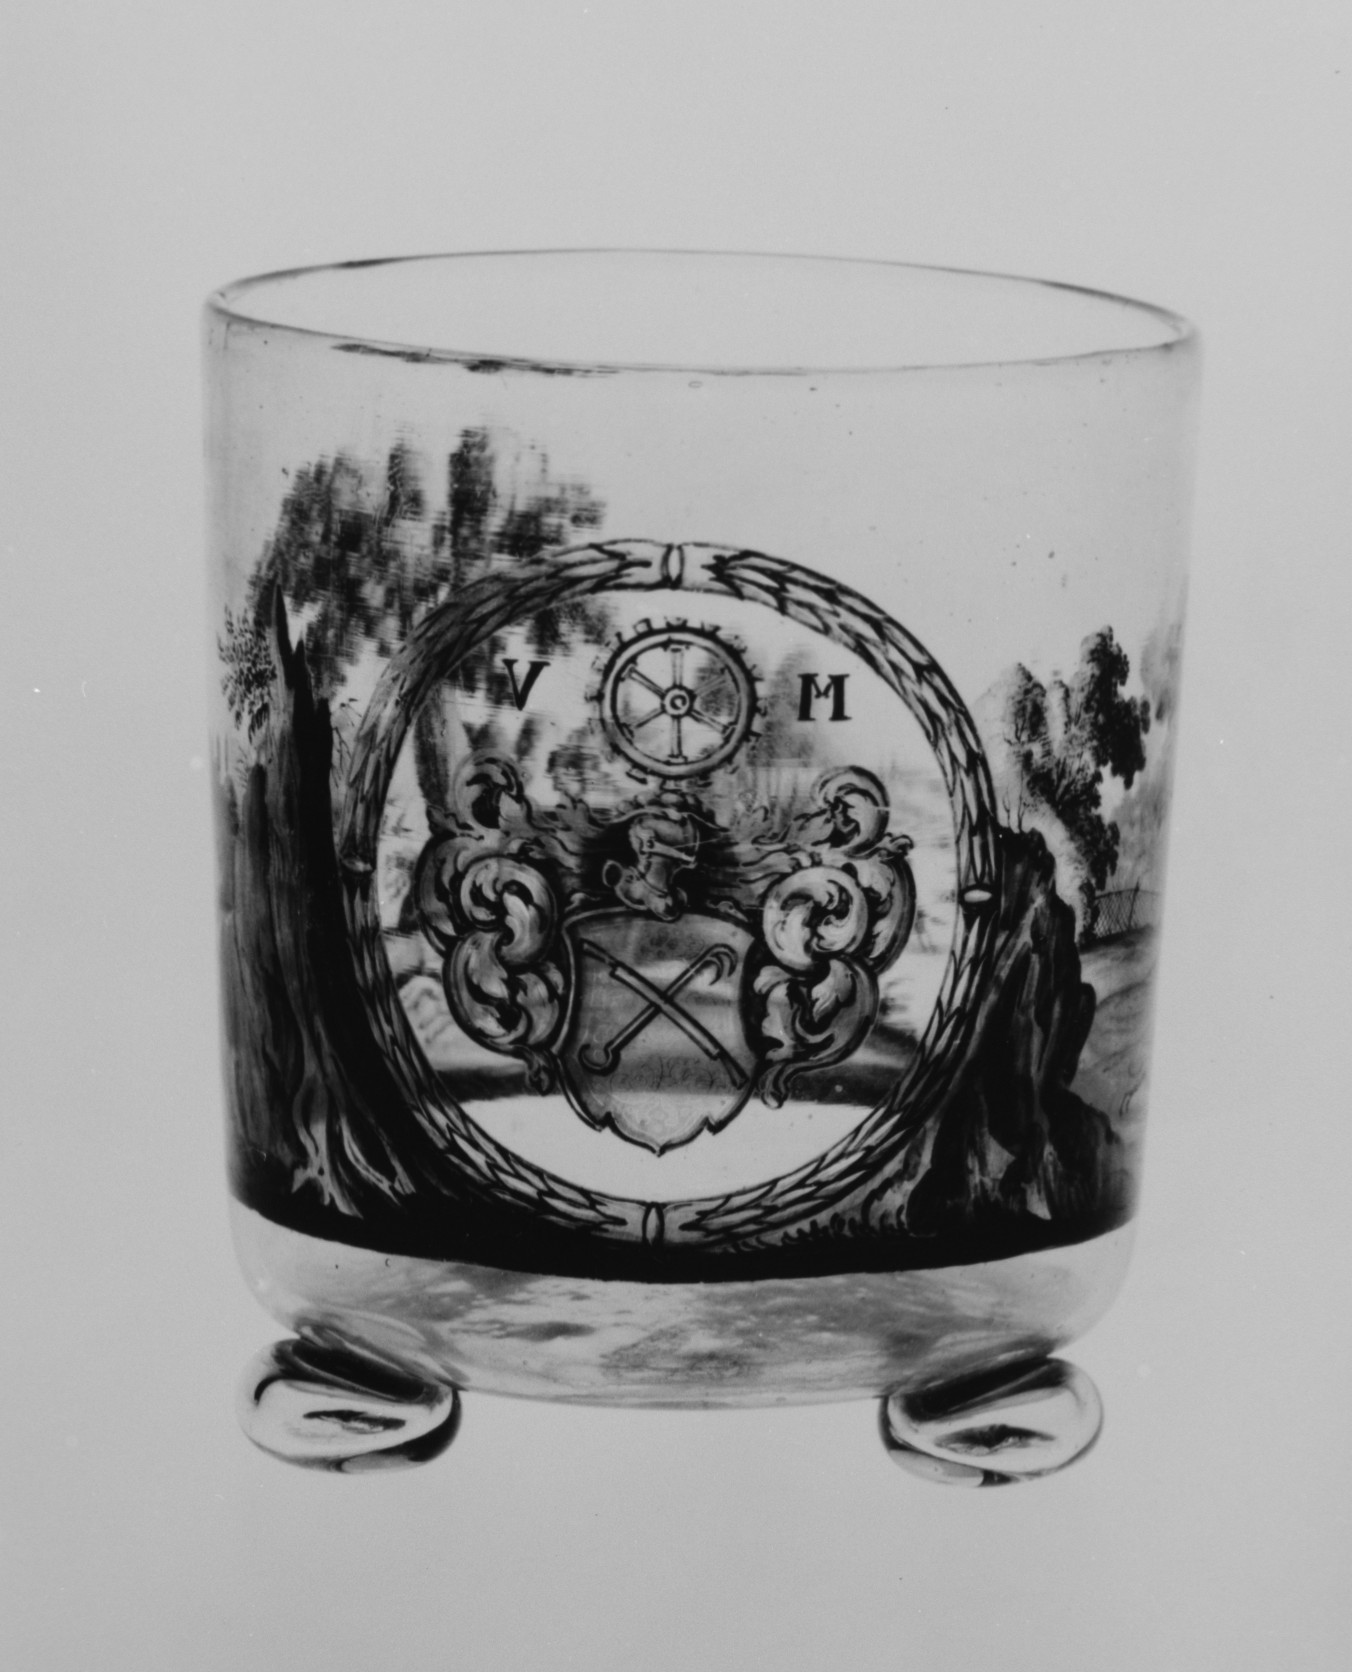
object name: beaker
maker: johann ludwig faber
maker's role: enameler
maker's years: 1648-1727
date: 1600-1670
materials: glass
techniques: enamel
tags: coat of arms